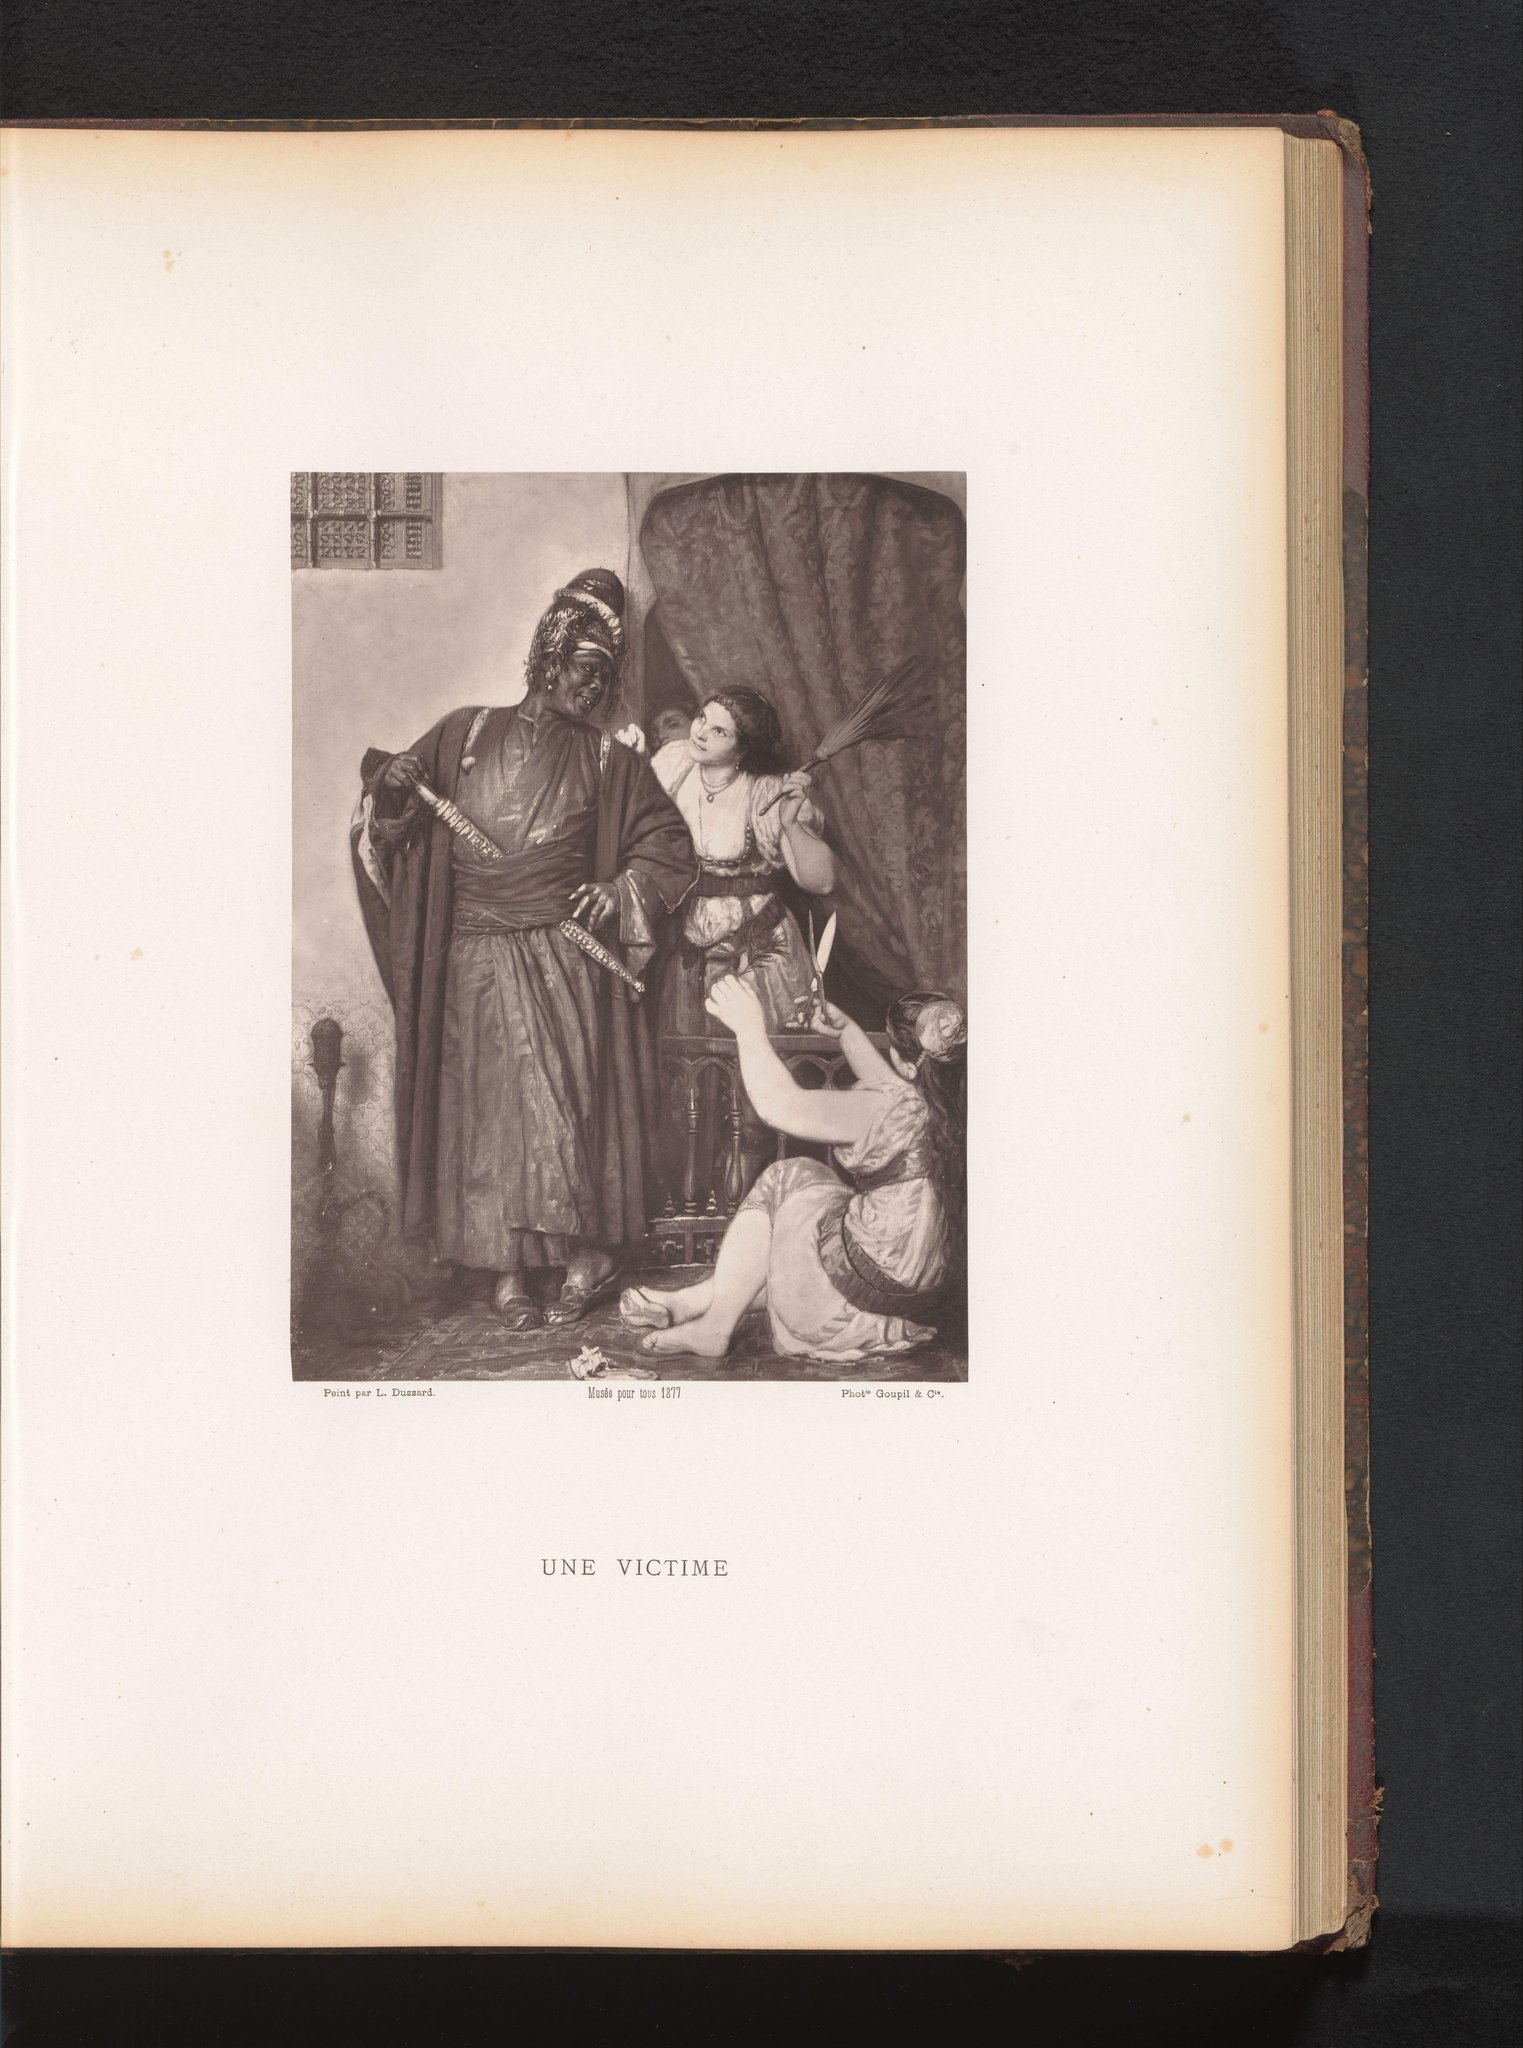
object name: page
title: Reproductie van een schilderij van een slachtoffer door L. Dussard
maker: l. dussard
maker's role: painter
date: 1872-1879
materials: paper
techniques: woodburytype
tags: the victim ~ rape, violation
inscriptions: inscription: ‘Musée pour tous 1877’